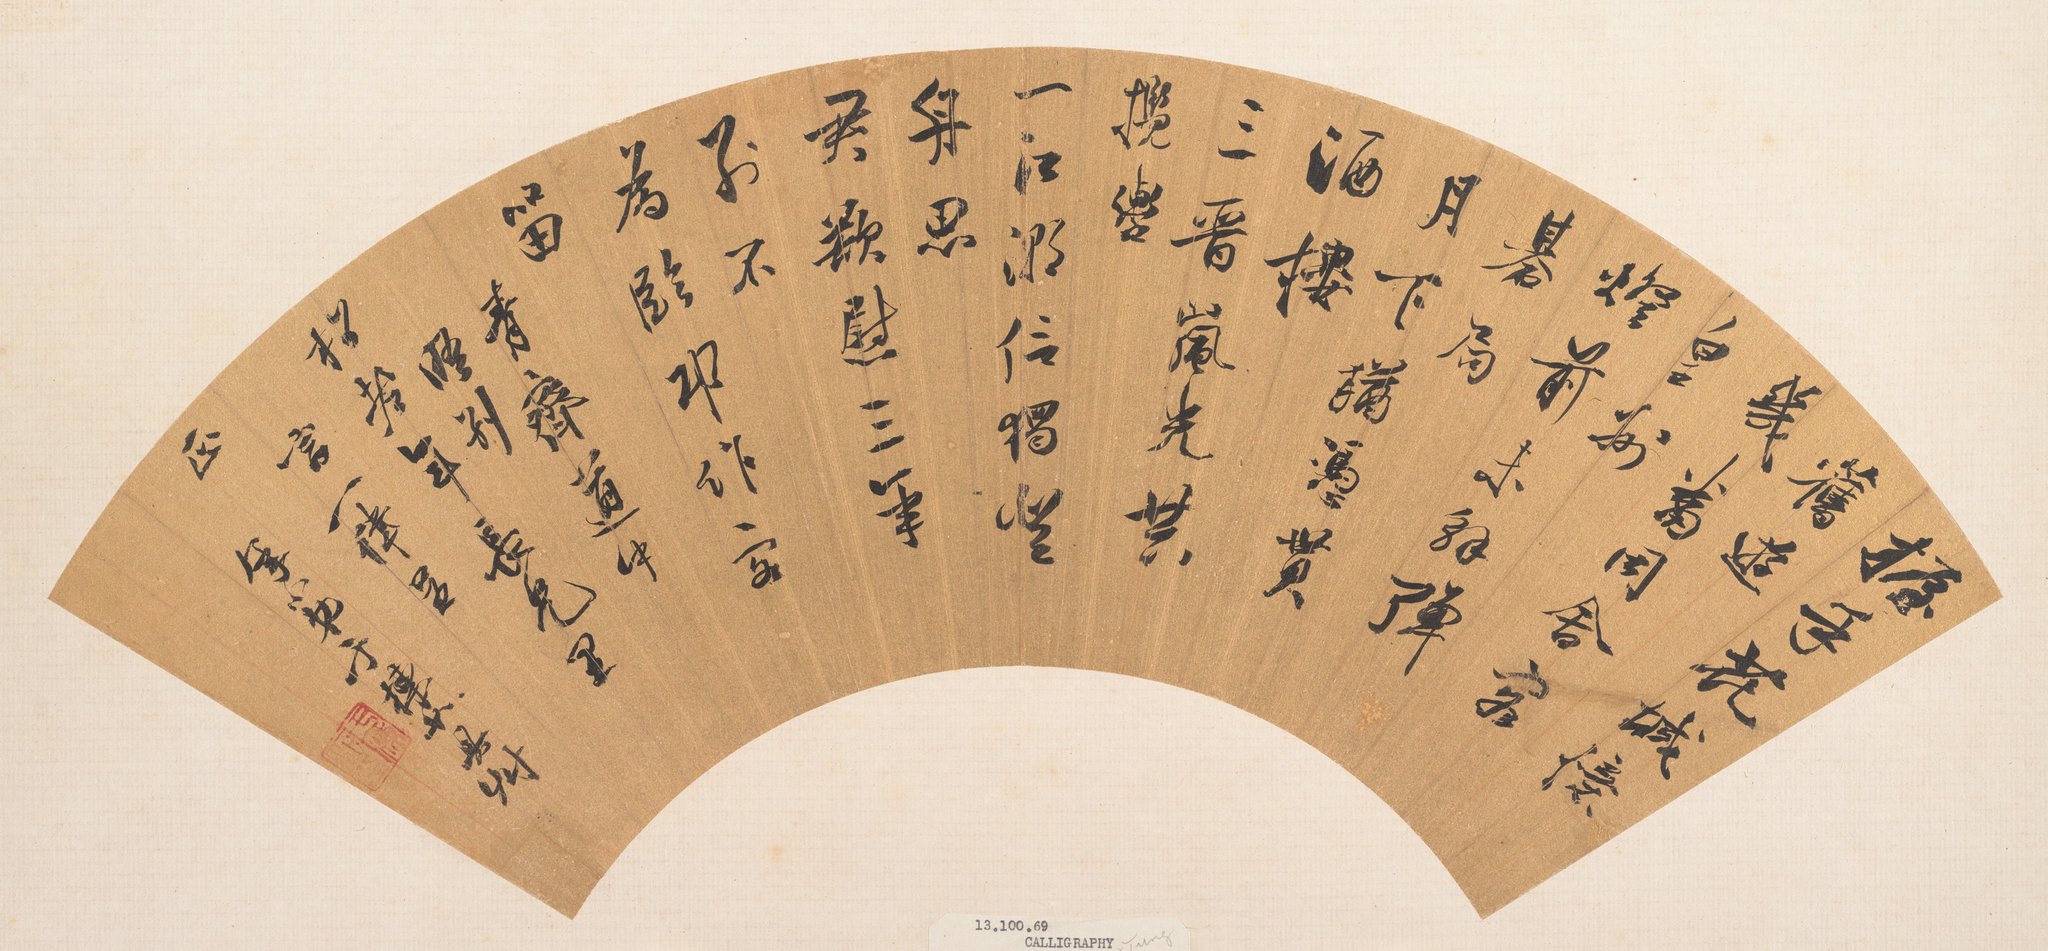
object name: folding fan mounted a an album leaf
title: Calligraphy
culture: chinese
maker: yu dongru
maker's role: artist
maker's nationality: chinese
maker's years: 1350-1650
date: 1667-1700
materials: ink, paper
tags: calligraphy